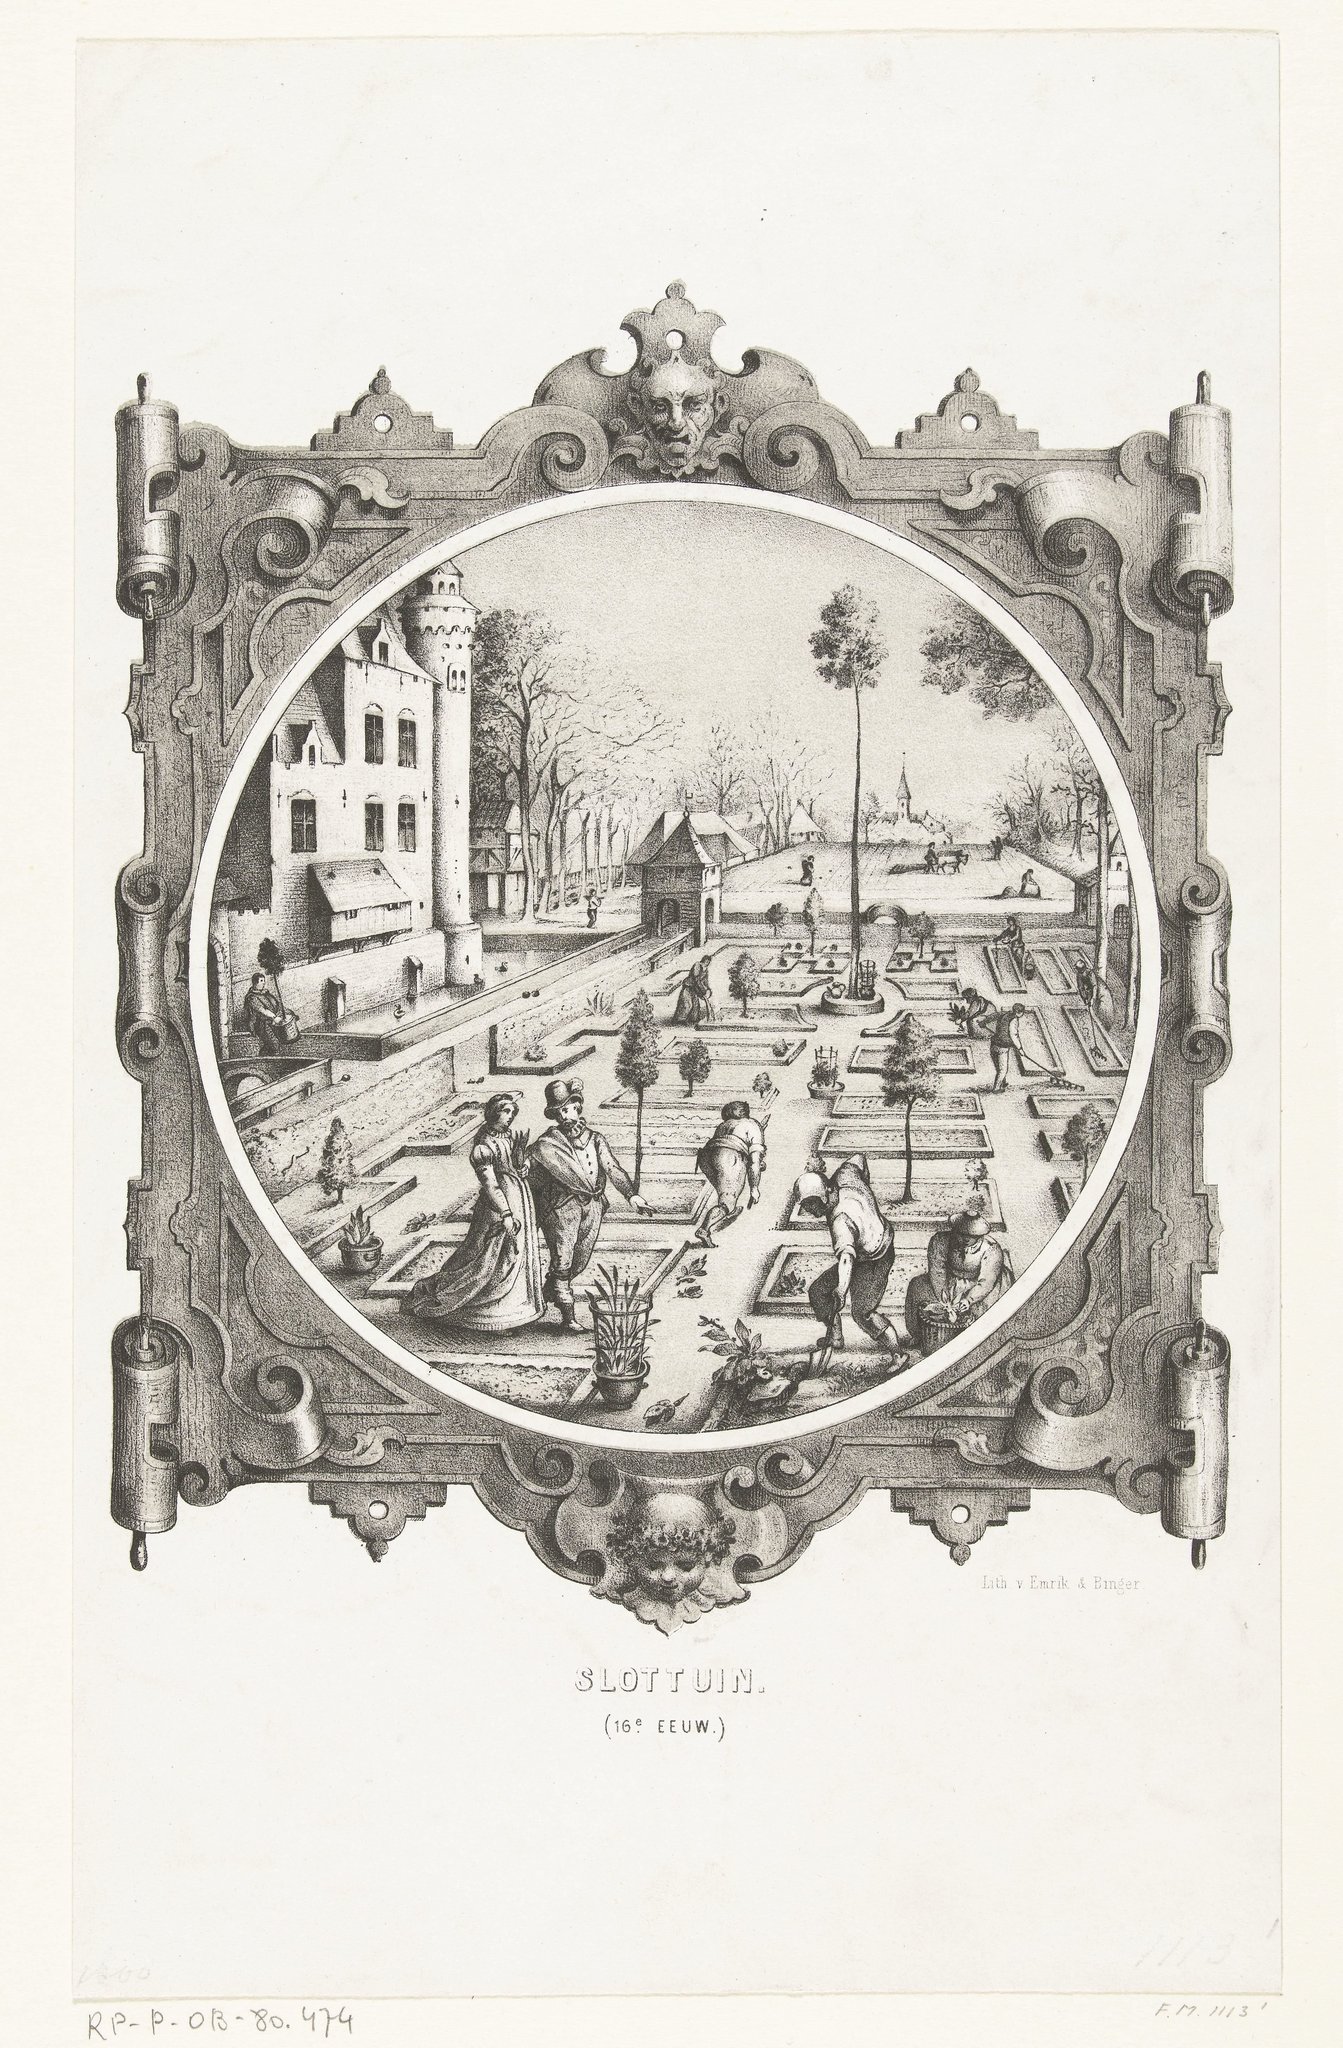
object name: print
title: Slottuin, ca. 1600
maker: Anonymous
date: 1857-1864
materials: paper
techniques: tone lithography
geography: netherlands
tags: garden, low countries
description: Slottuin, ca. 1600. Een elegant paar wandelend door een tuin waarin getuinierd wordt. Links een kasteel. Voorstelling in omlijsting met rolwerk.